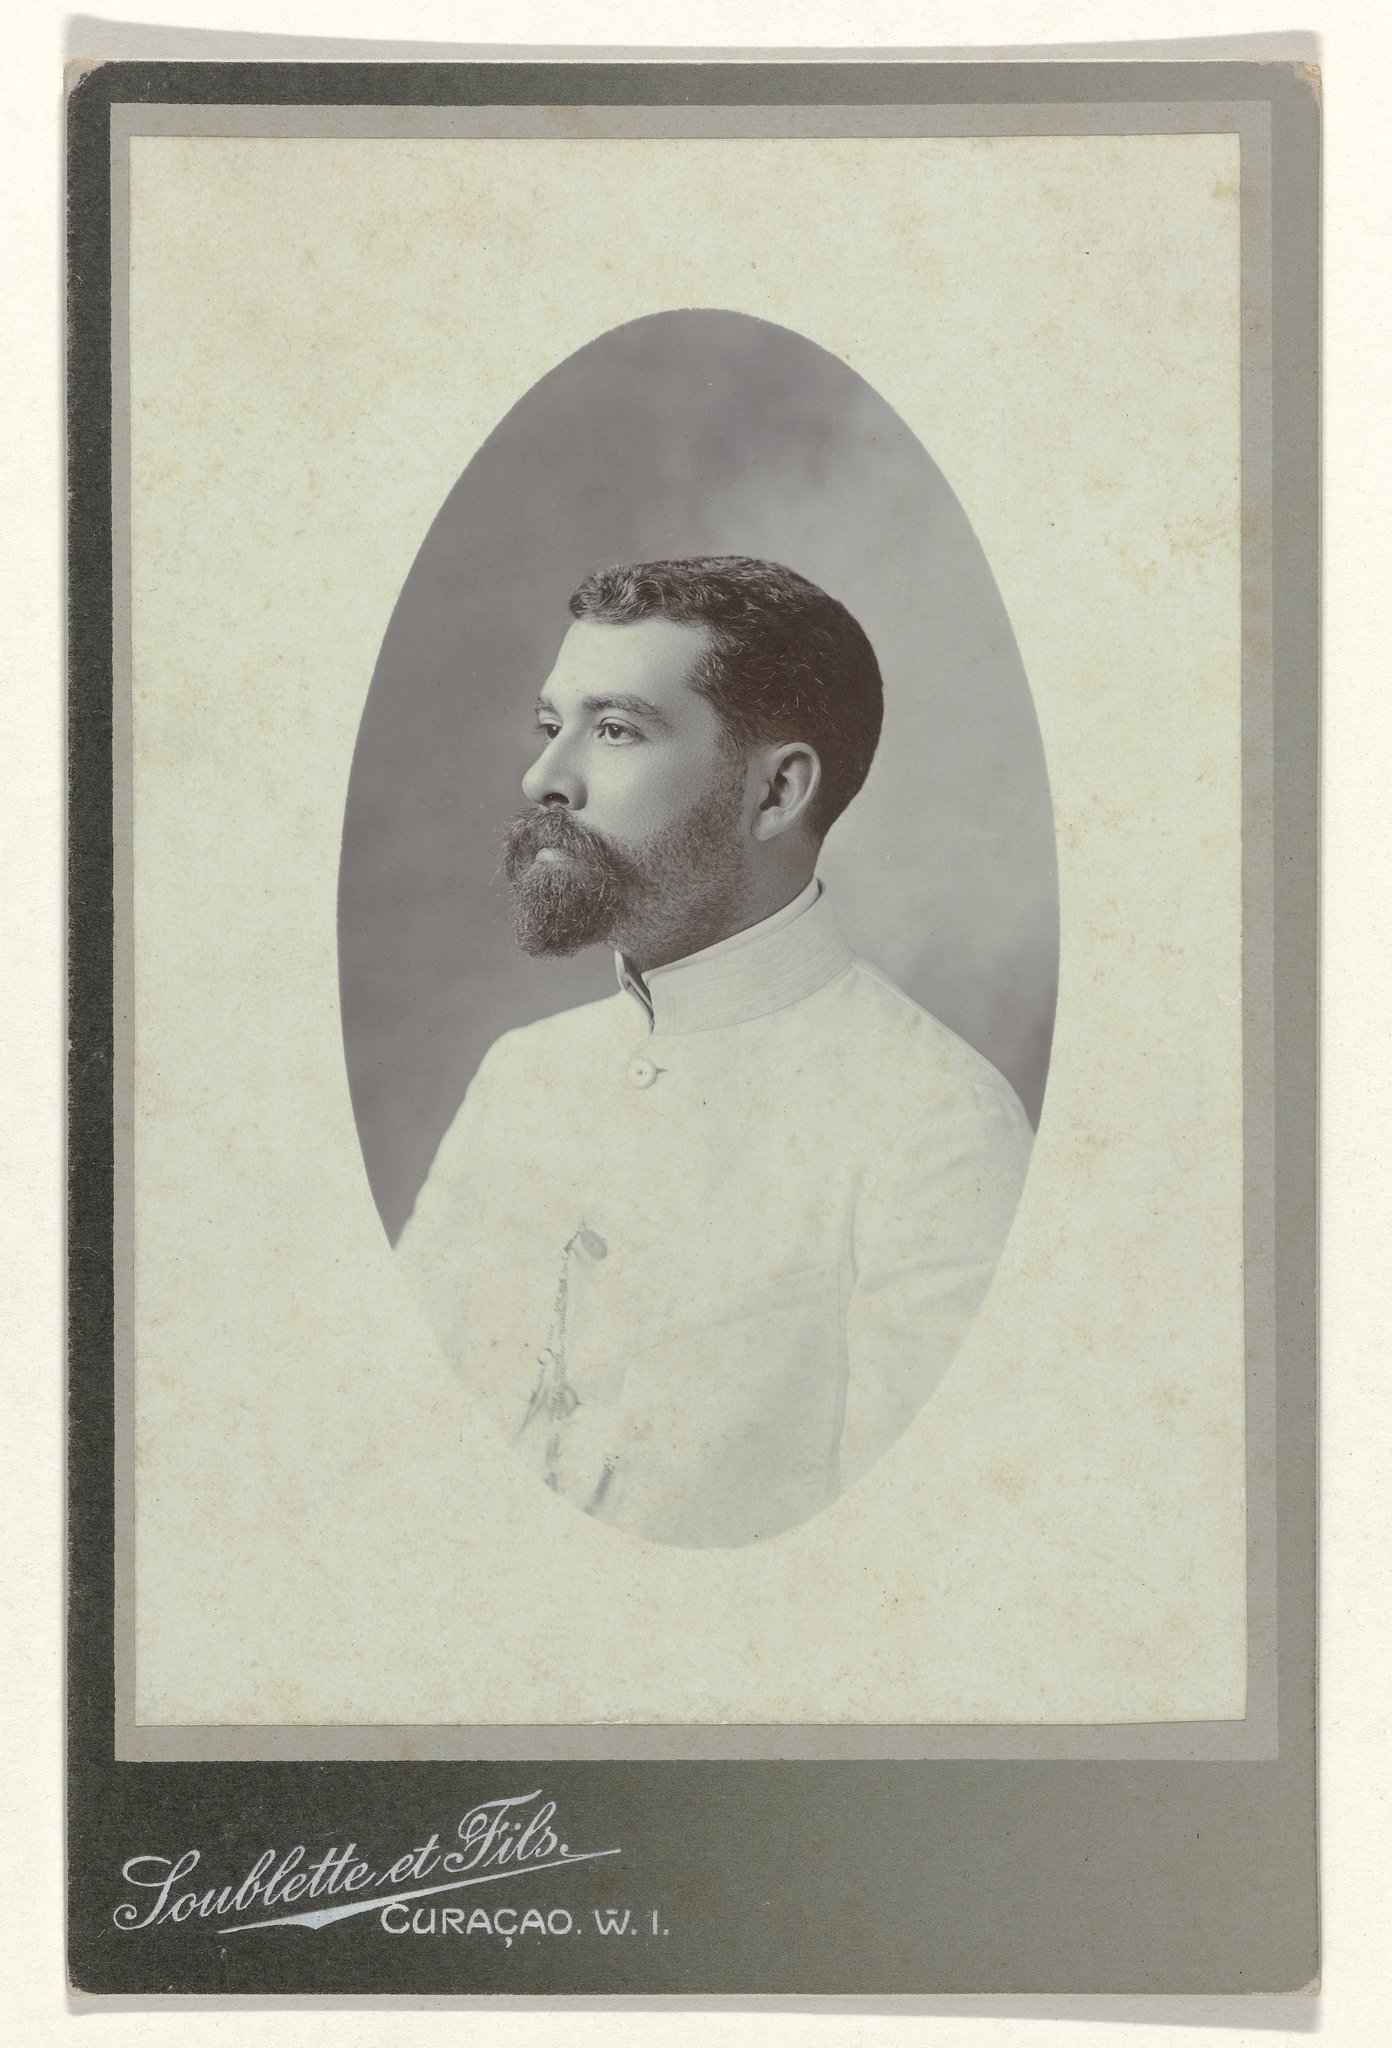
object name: cabinet photograph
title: Portret van Constant van Hall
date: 1905-1908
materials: cardboard, photographic support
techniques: photography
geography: curacao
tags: wetenschapper, constant johann jakob van hall, curaçao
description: Portret van de wetenschapper Constant Johann Jakob van Hall (dokter C.J.J. van Hall) te Curaçao. Onderdeel van een groep foto's van de familie Boom-Gonggrijp in Suriname.